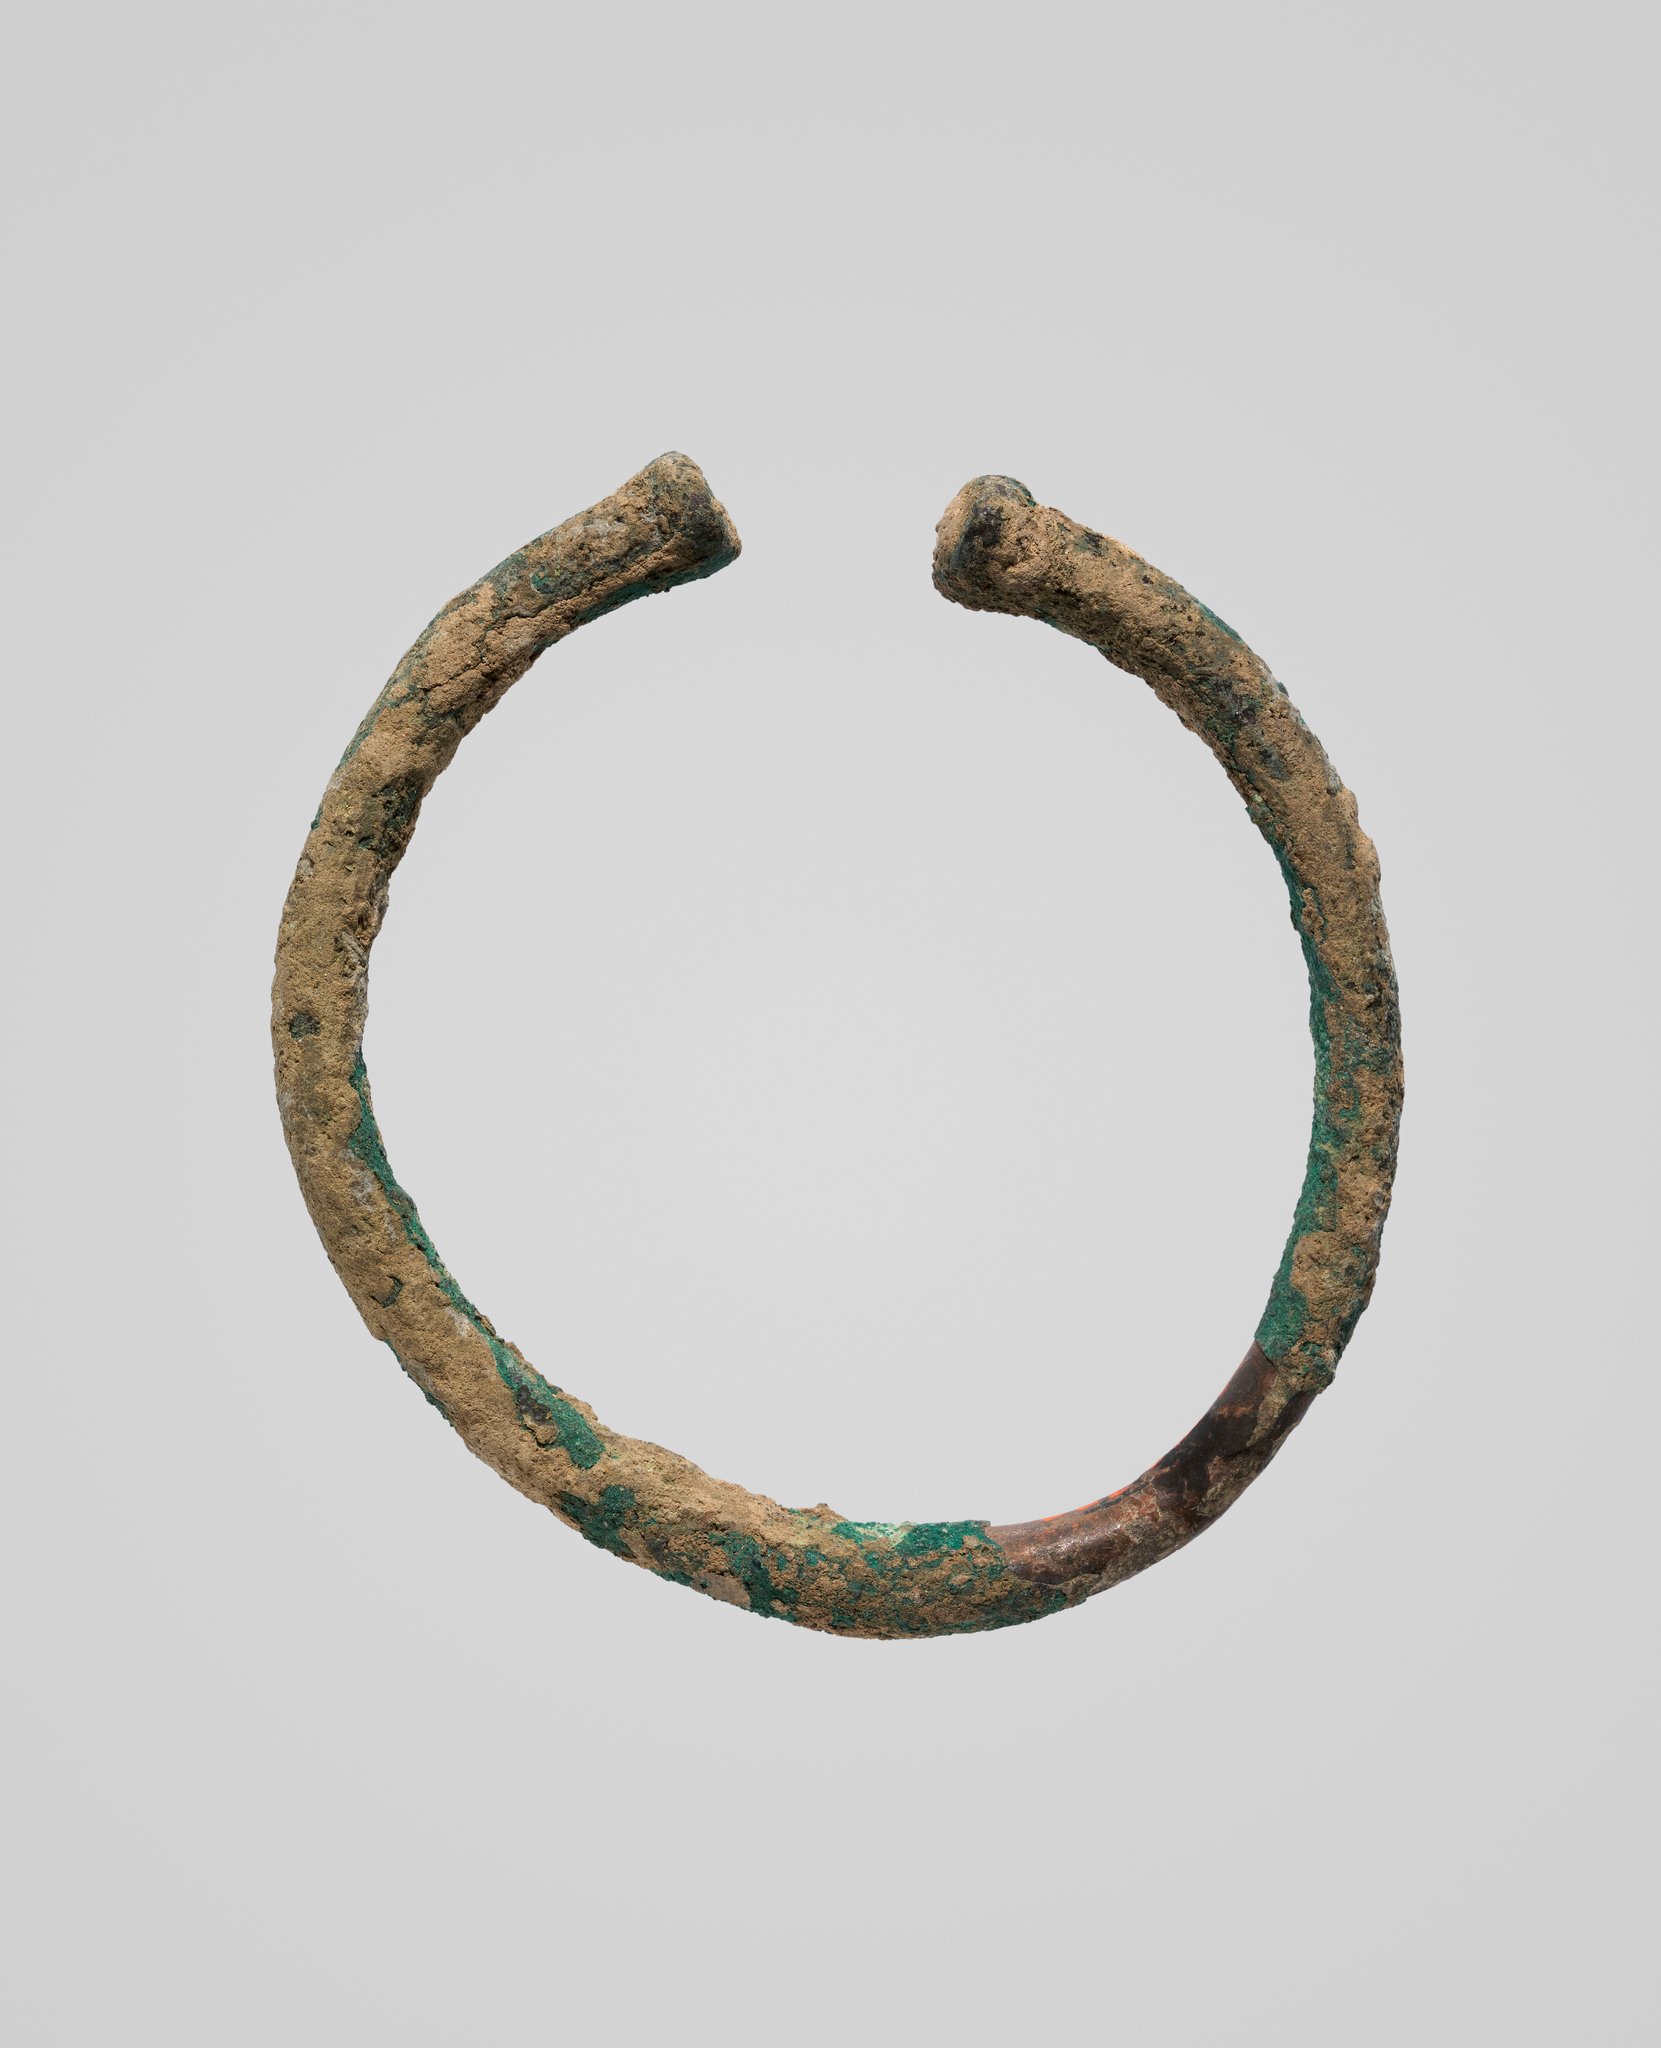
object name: bracelet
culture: sasanian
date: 201-700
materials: bronze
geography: mesopotamia